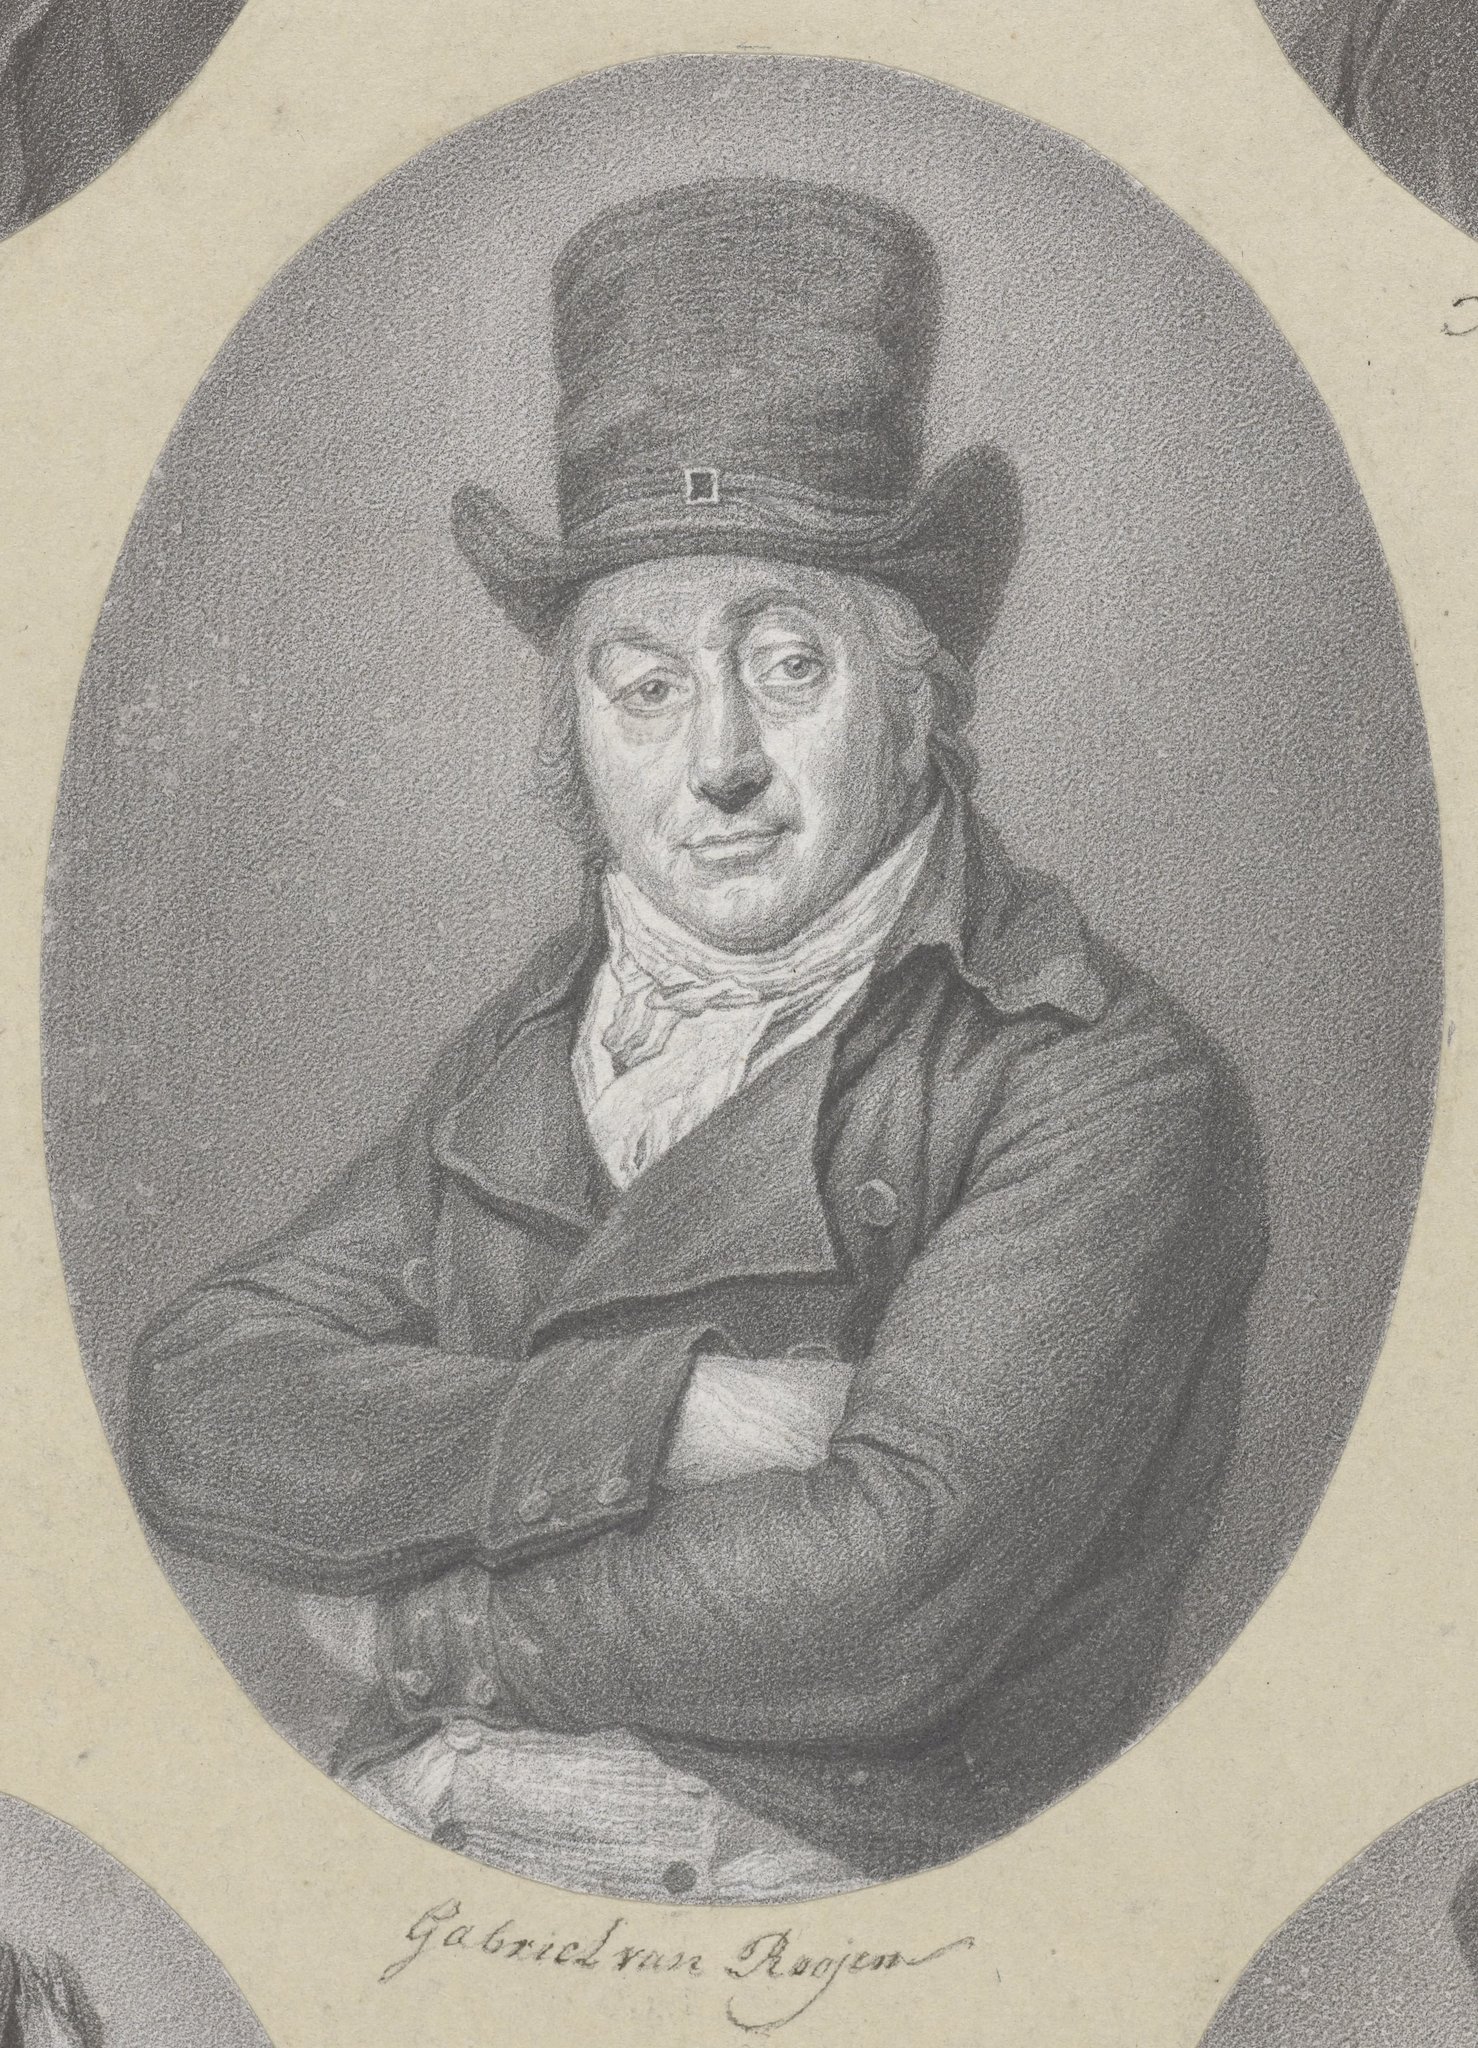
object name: drawing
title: Portret van Gabriël van Roojen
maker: johannes cornelis mertens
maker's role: draughtsman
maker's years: 1742-1823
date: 1797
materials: chalk, paper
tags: historical persons